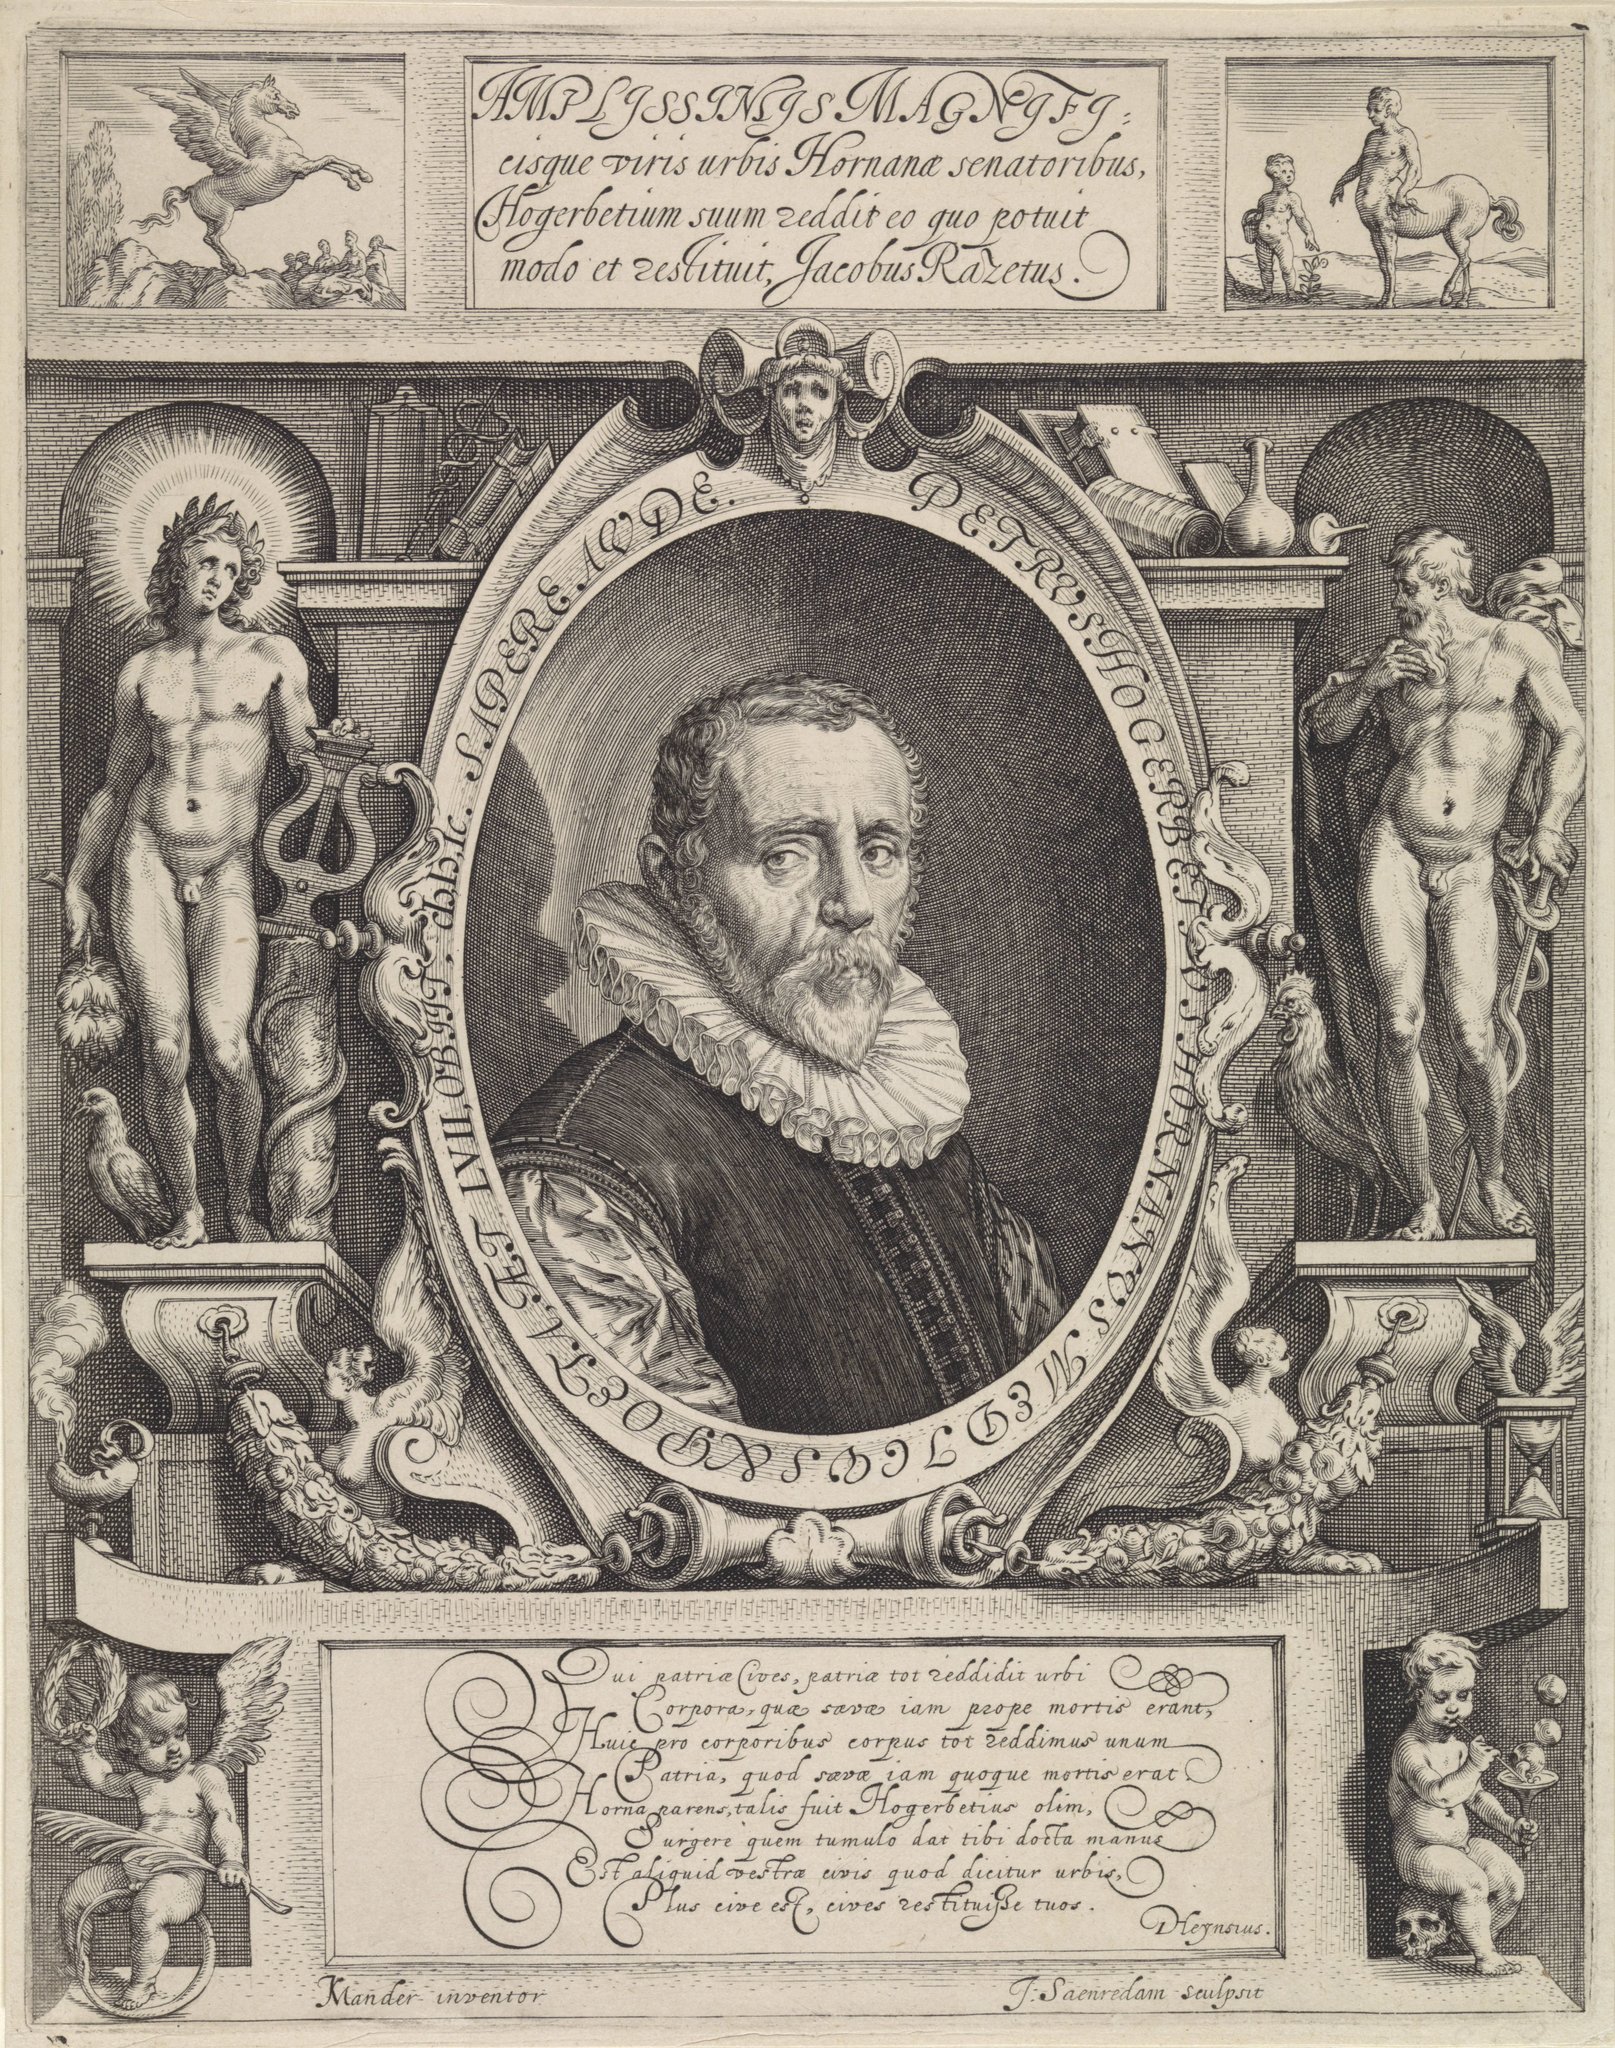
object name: print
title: Portret van Petrus Hogerbeets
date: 1599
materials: paper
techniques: engraving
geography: amsterdam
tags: petrus hogerbeets, apollo medicus, aesculapius instructed by chiron, historical persons, aesculapius as patron of medicine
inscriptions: collector's mark: Lugt 240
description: Buste naar rechts van de arts en dichter Petrus Hogerbeets in een ovale omlijsting met een Latijnse randtekst, die informatie bevat over de geportretteerde. Links staat Apollo als Apollo Medicus op een console bij een zuil met een slang. Hij houdt een harp vast. Bij zijn rechtervoet een kraai, die over Coronis had moeten waken. Rechts staat Aesculapius bij een haan op een console. Hij houdt een esculaap vast. Boven de lijst medische instrumenten en boeken. Linksboven Pegasus die de Hippocrene doet ontspringen. Rechts de jonge Aesculapius bij de centaur Chiron, die hem heeft opgevoed. Tussen deze voorstellingen staat een Latijnse tekst met informatie over de geportretteerde. Linksonder en putto met een lauwerkrans, een palmtak en een slang die in zijn eigen staart bijt als symbool van eeuwigheid. Rechtsonder een putto op een schedel, die bellen blaast als vanitassymbool. Tussen de putti een achtregelige, Latijnse tekst.